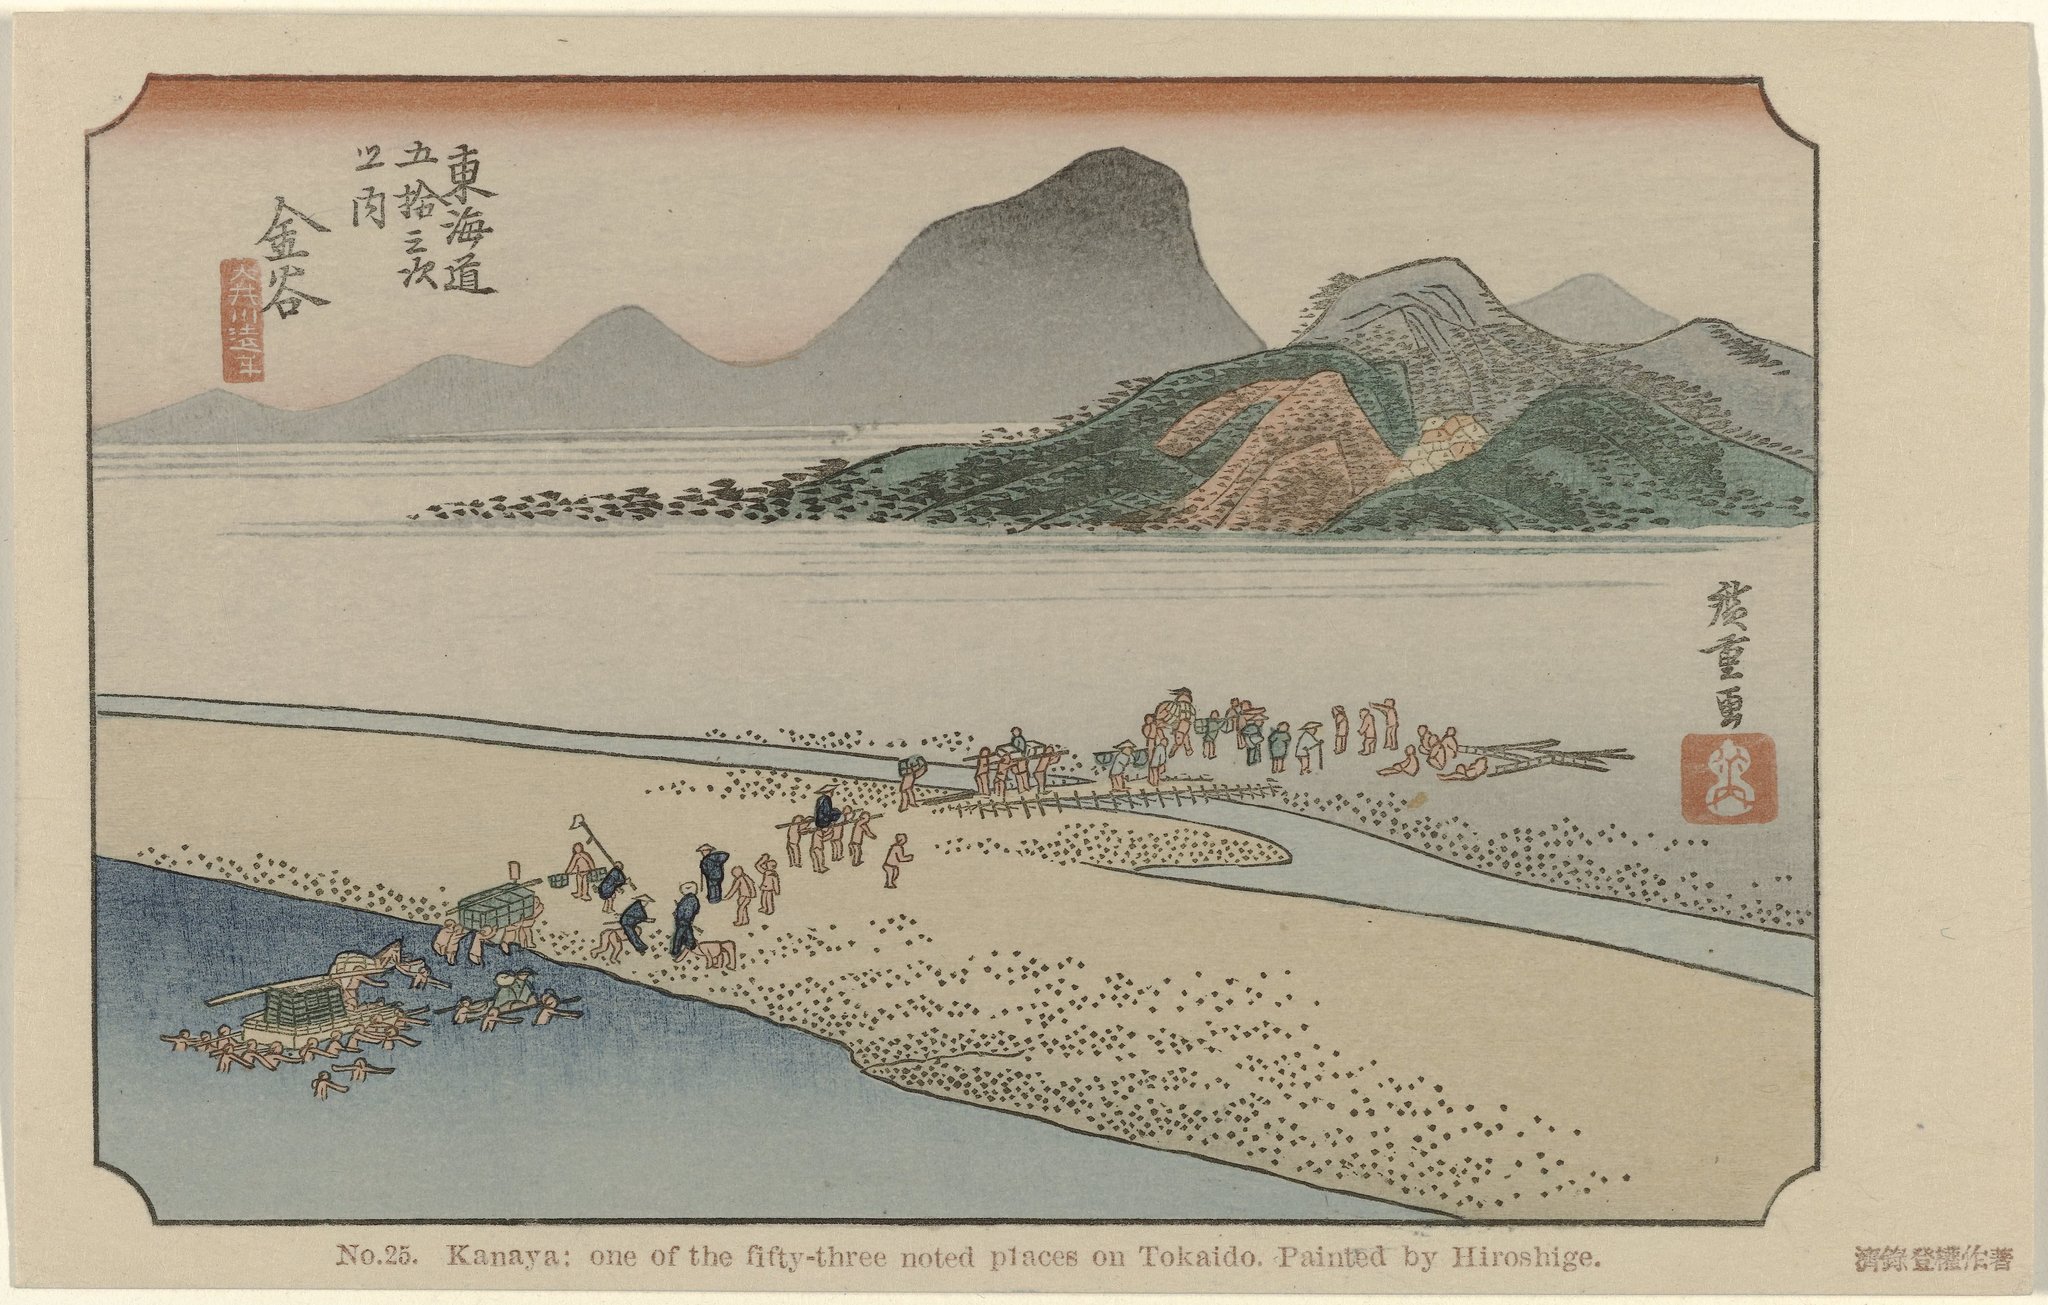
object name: ansichtkaart, prentbriefkaart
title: Hiroshige no fude Tôkaidô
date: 1906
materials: cardboard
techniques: woodcut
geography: japan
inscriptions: date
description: Een processie van een daimyo steekt een rivier over.